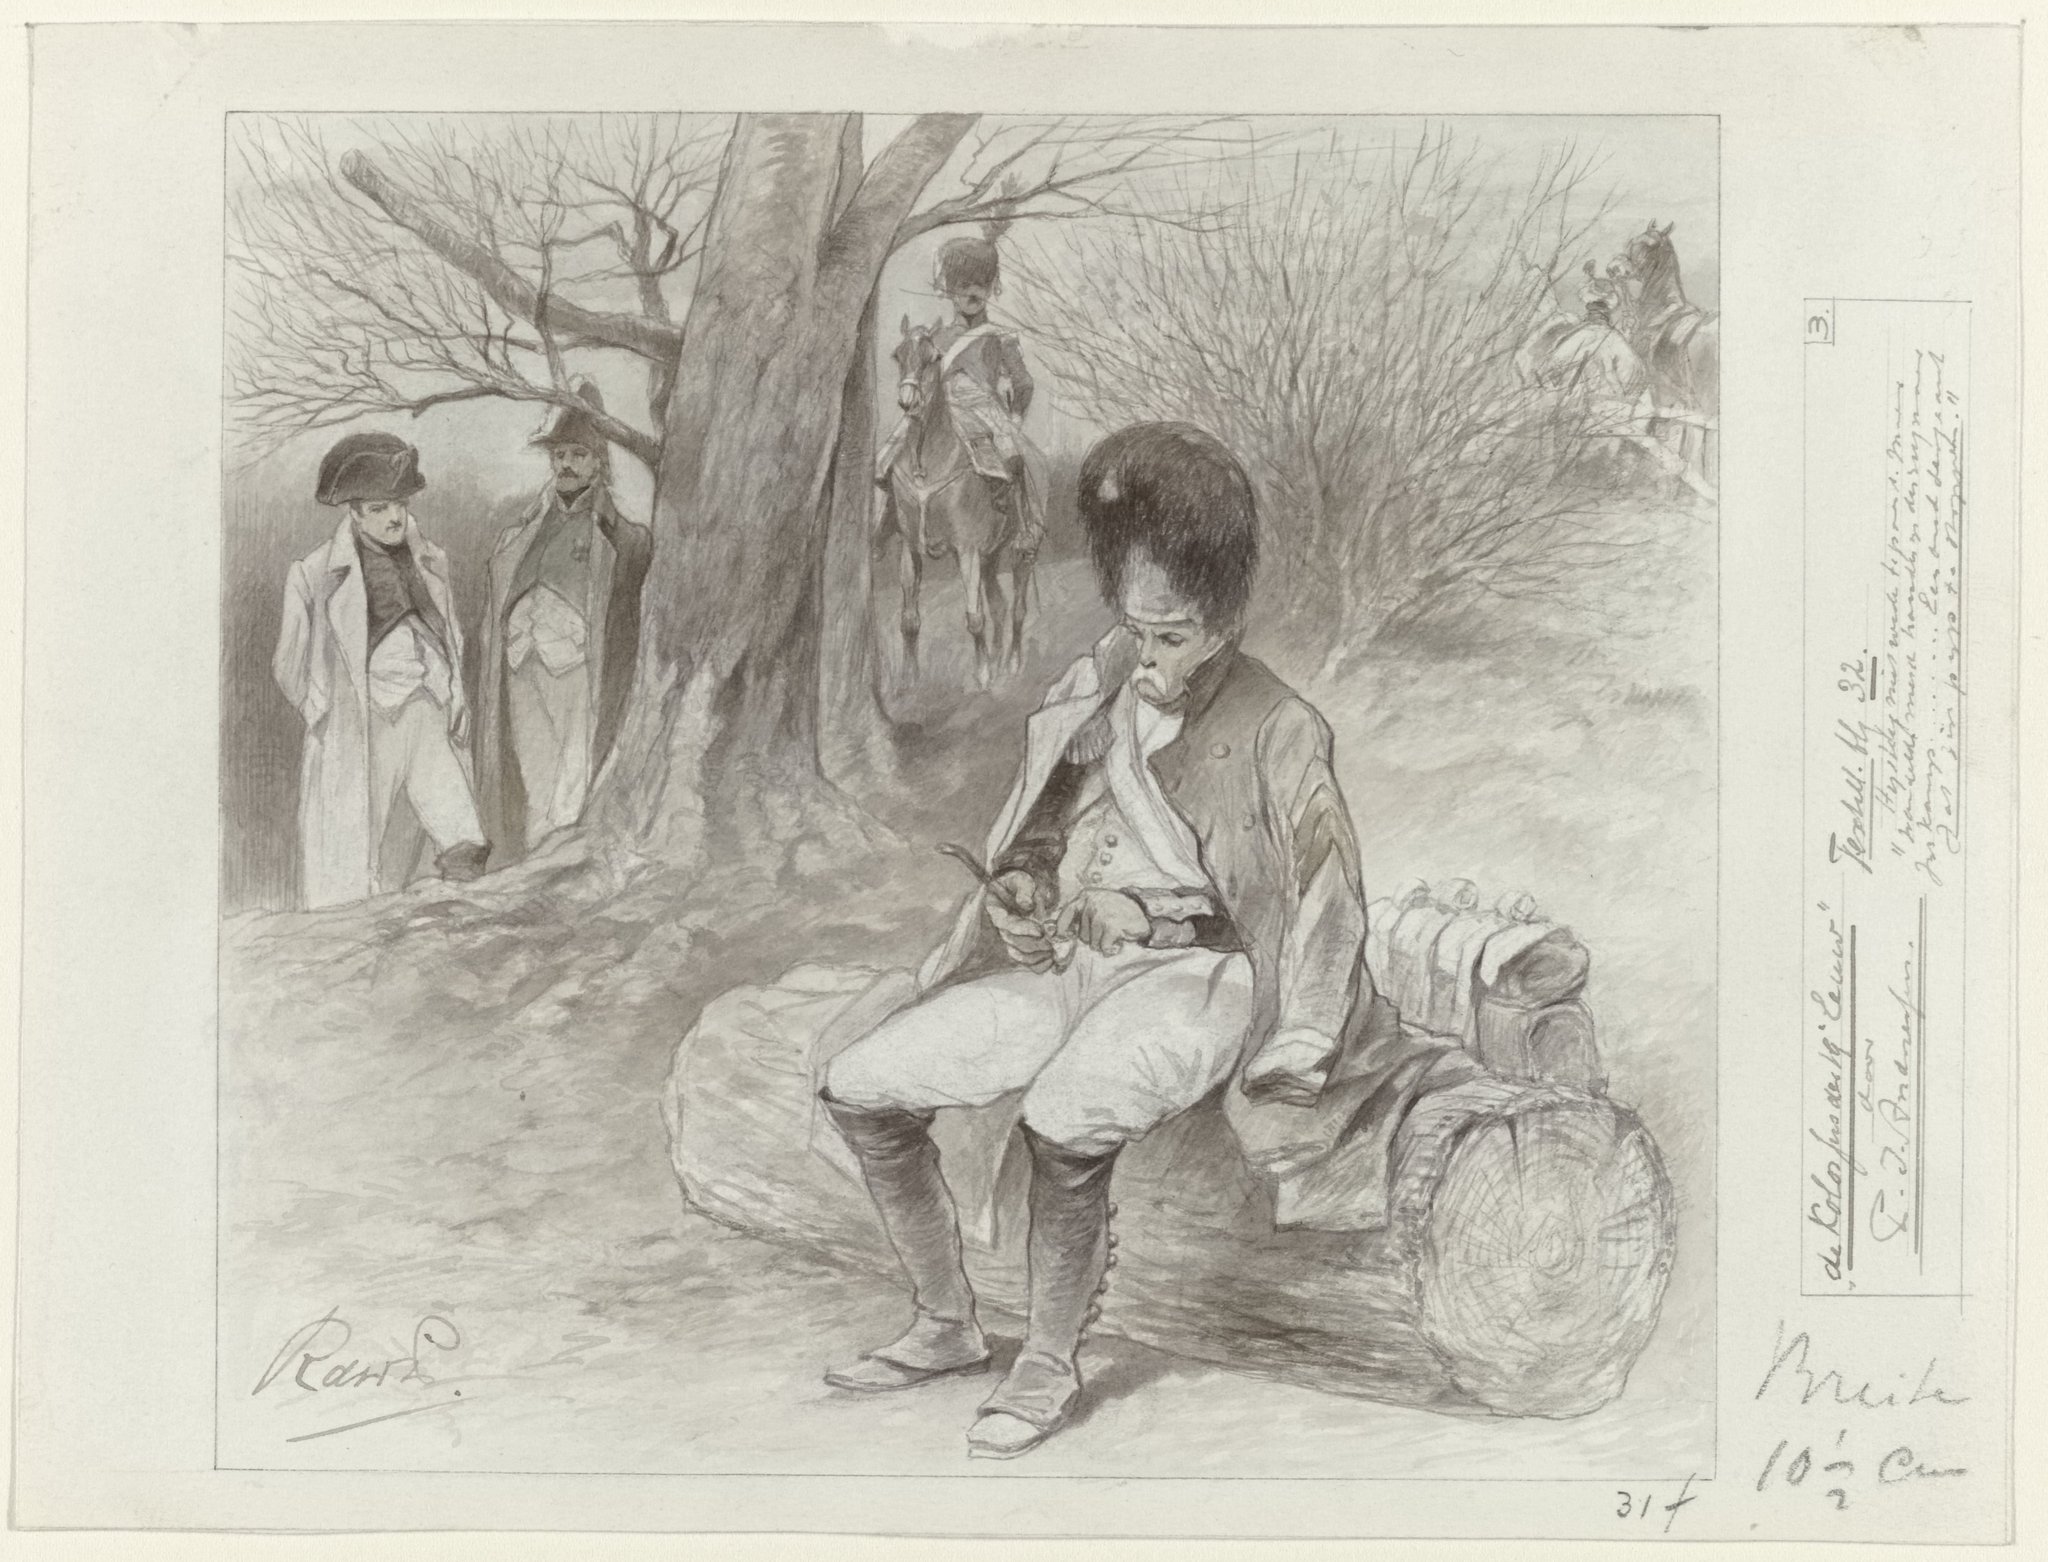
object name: drawing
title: Ontwerp voor illustratie voor De Kolossus der Negentiende Eeuw door P.J. Andriessen (Textill., blz. 32); scène uit het leven van Napoleon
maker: george lodewijk de wetstein pfister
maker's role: draughtsman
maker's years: 1867-1942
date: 1877-1942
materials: ink, paper, pencil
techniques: brush, pen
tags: napoleon i (emperor of the french), (andriessen, de kolossus der negentiende eeuw) specific works of literature (with author, title), historical persons, illustration ~ printed matter, book, historical events and situations